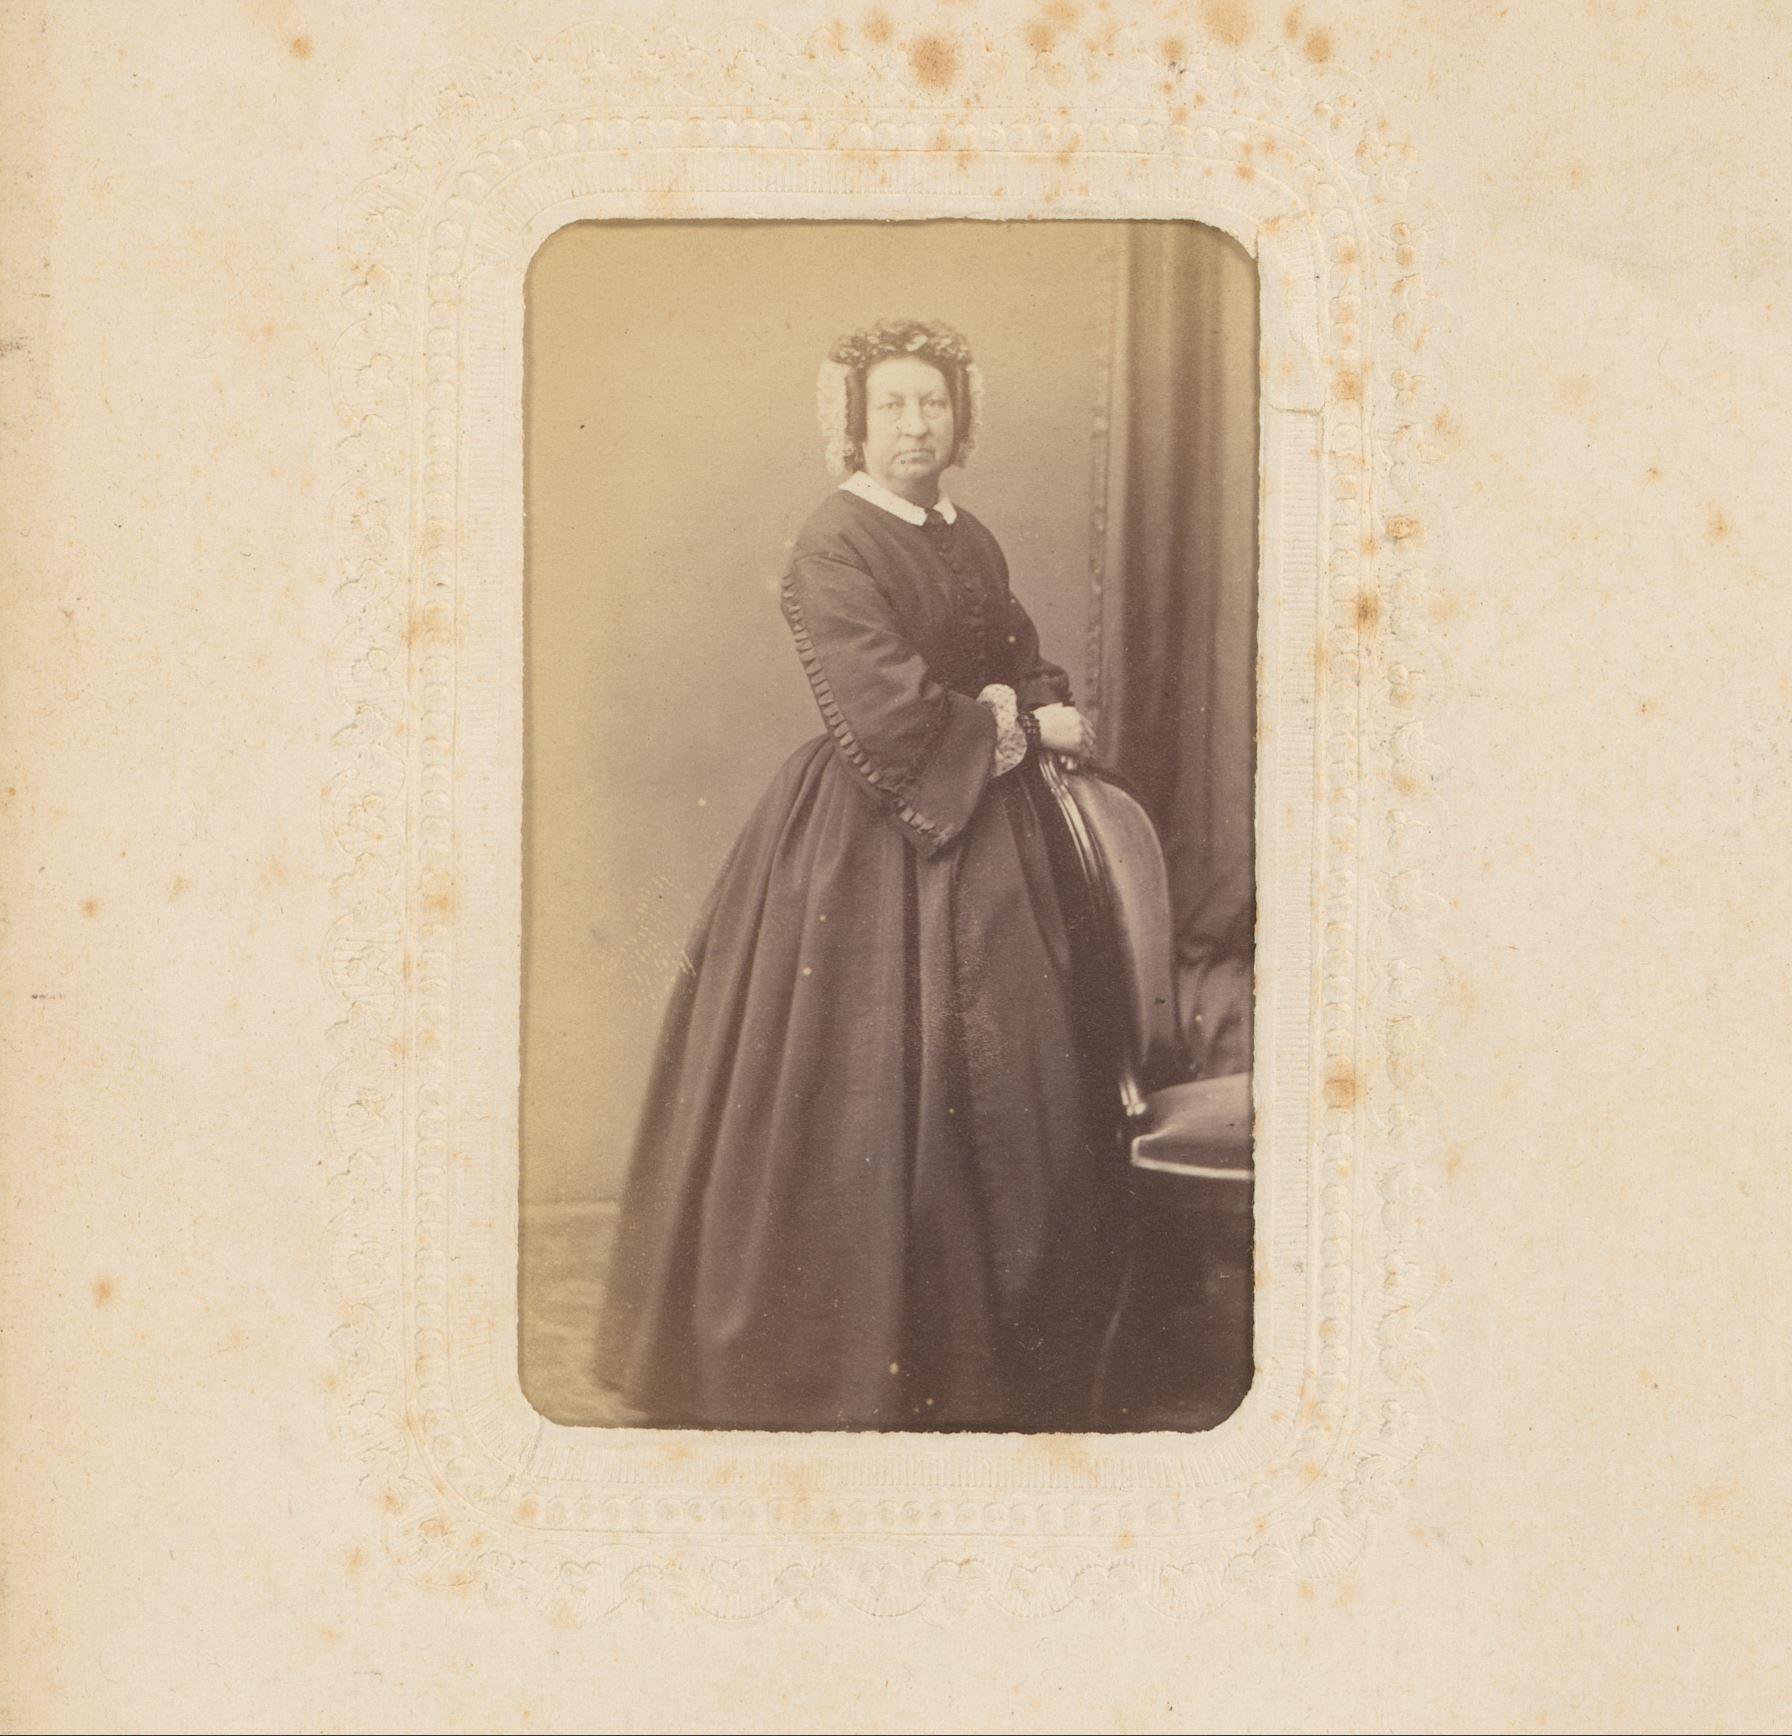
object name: carte de visite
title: Portret van een vrouw met muts, staand bij een stoel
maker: françois deron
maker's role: fotograaf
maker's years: 1819-1876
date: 1853-1876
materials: cardboard, photographic support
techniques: albumen print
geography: brussels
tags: standing figure, historical persons - bb - woman, head-gear: hat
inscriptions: inscription: ‘F. Deron/ photographie/ 13, Rue de la Madeleine, 13/ Bruxelles’